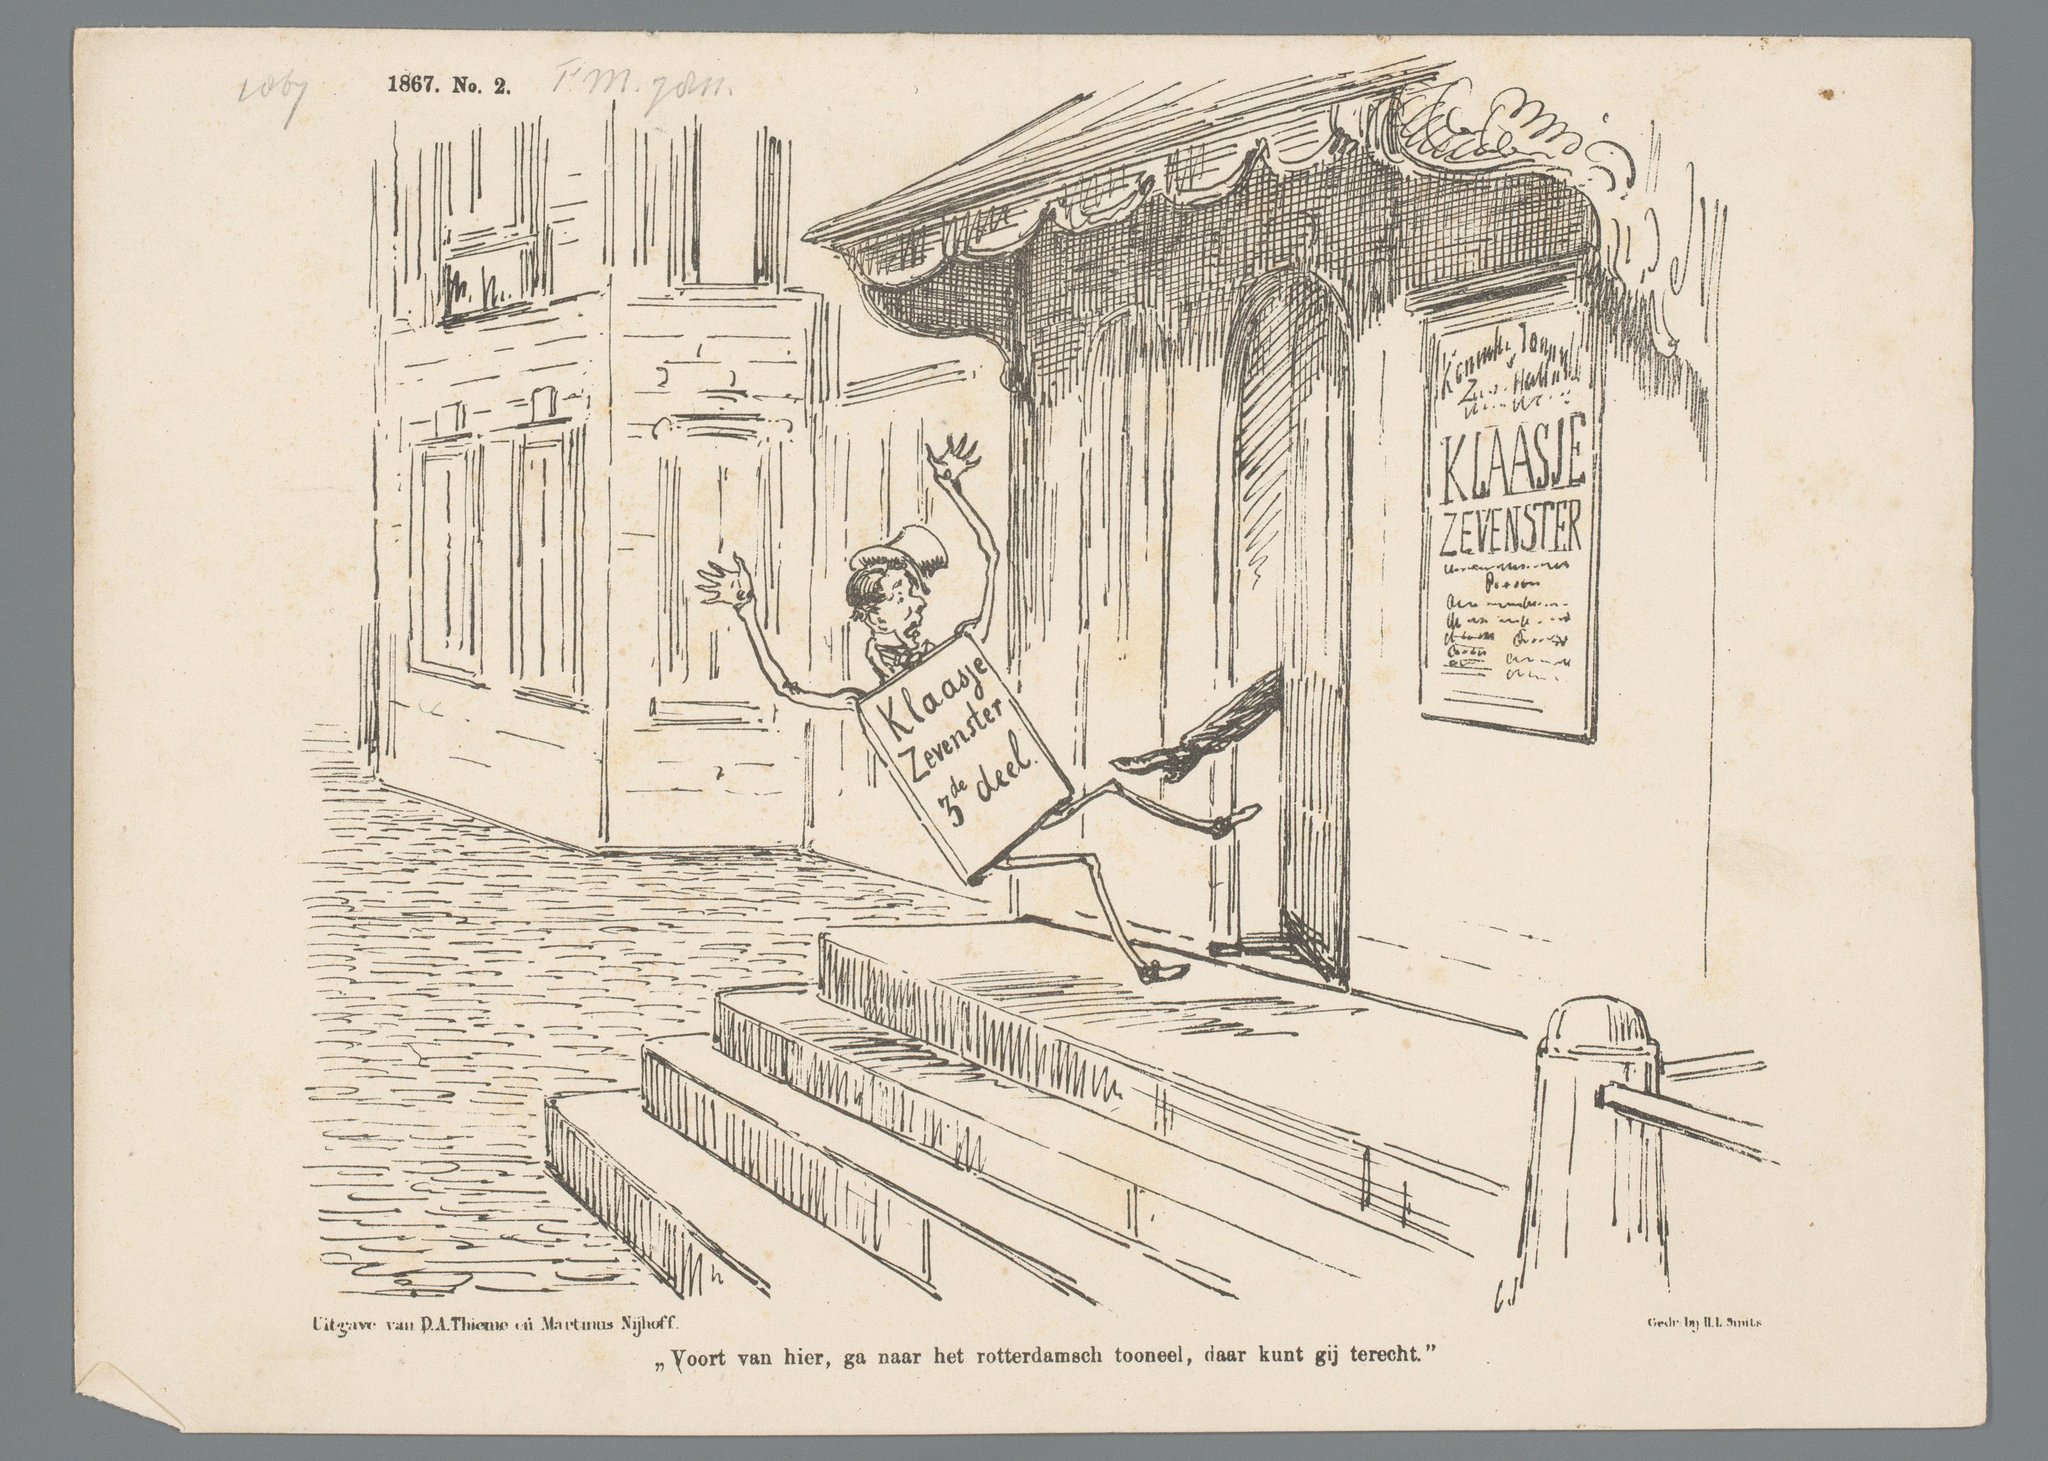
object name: cartoon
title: Spotprent op de opvoering van Klaasje Zevenster, 1867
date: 1867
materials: paper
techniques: lithograph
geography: the hague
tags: amsterdam, jacob van lennep, theatre, theatrical performance, theatre (building)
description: Spotprent op de mislukte opvoering van het toneelstuk Klaasje Zevenster van Jacob van Lennep in Den Haag terwijl het in Rotterdan een succes was, 1867. Plaat verschenen bij het weekblad De Nederlandsche Spectator, nr. 2, 12 januari 1867.